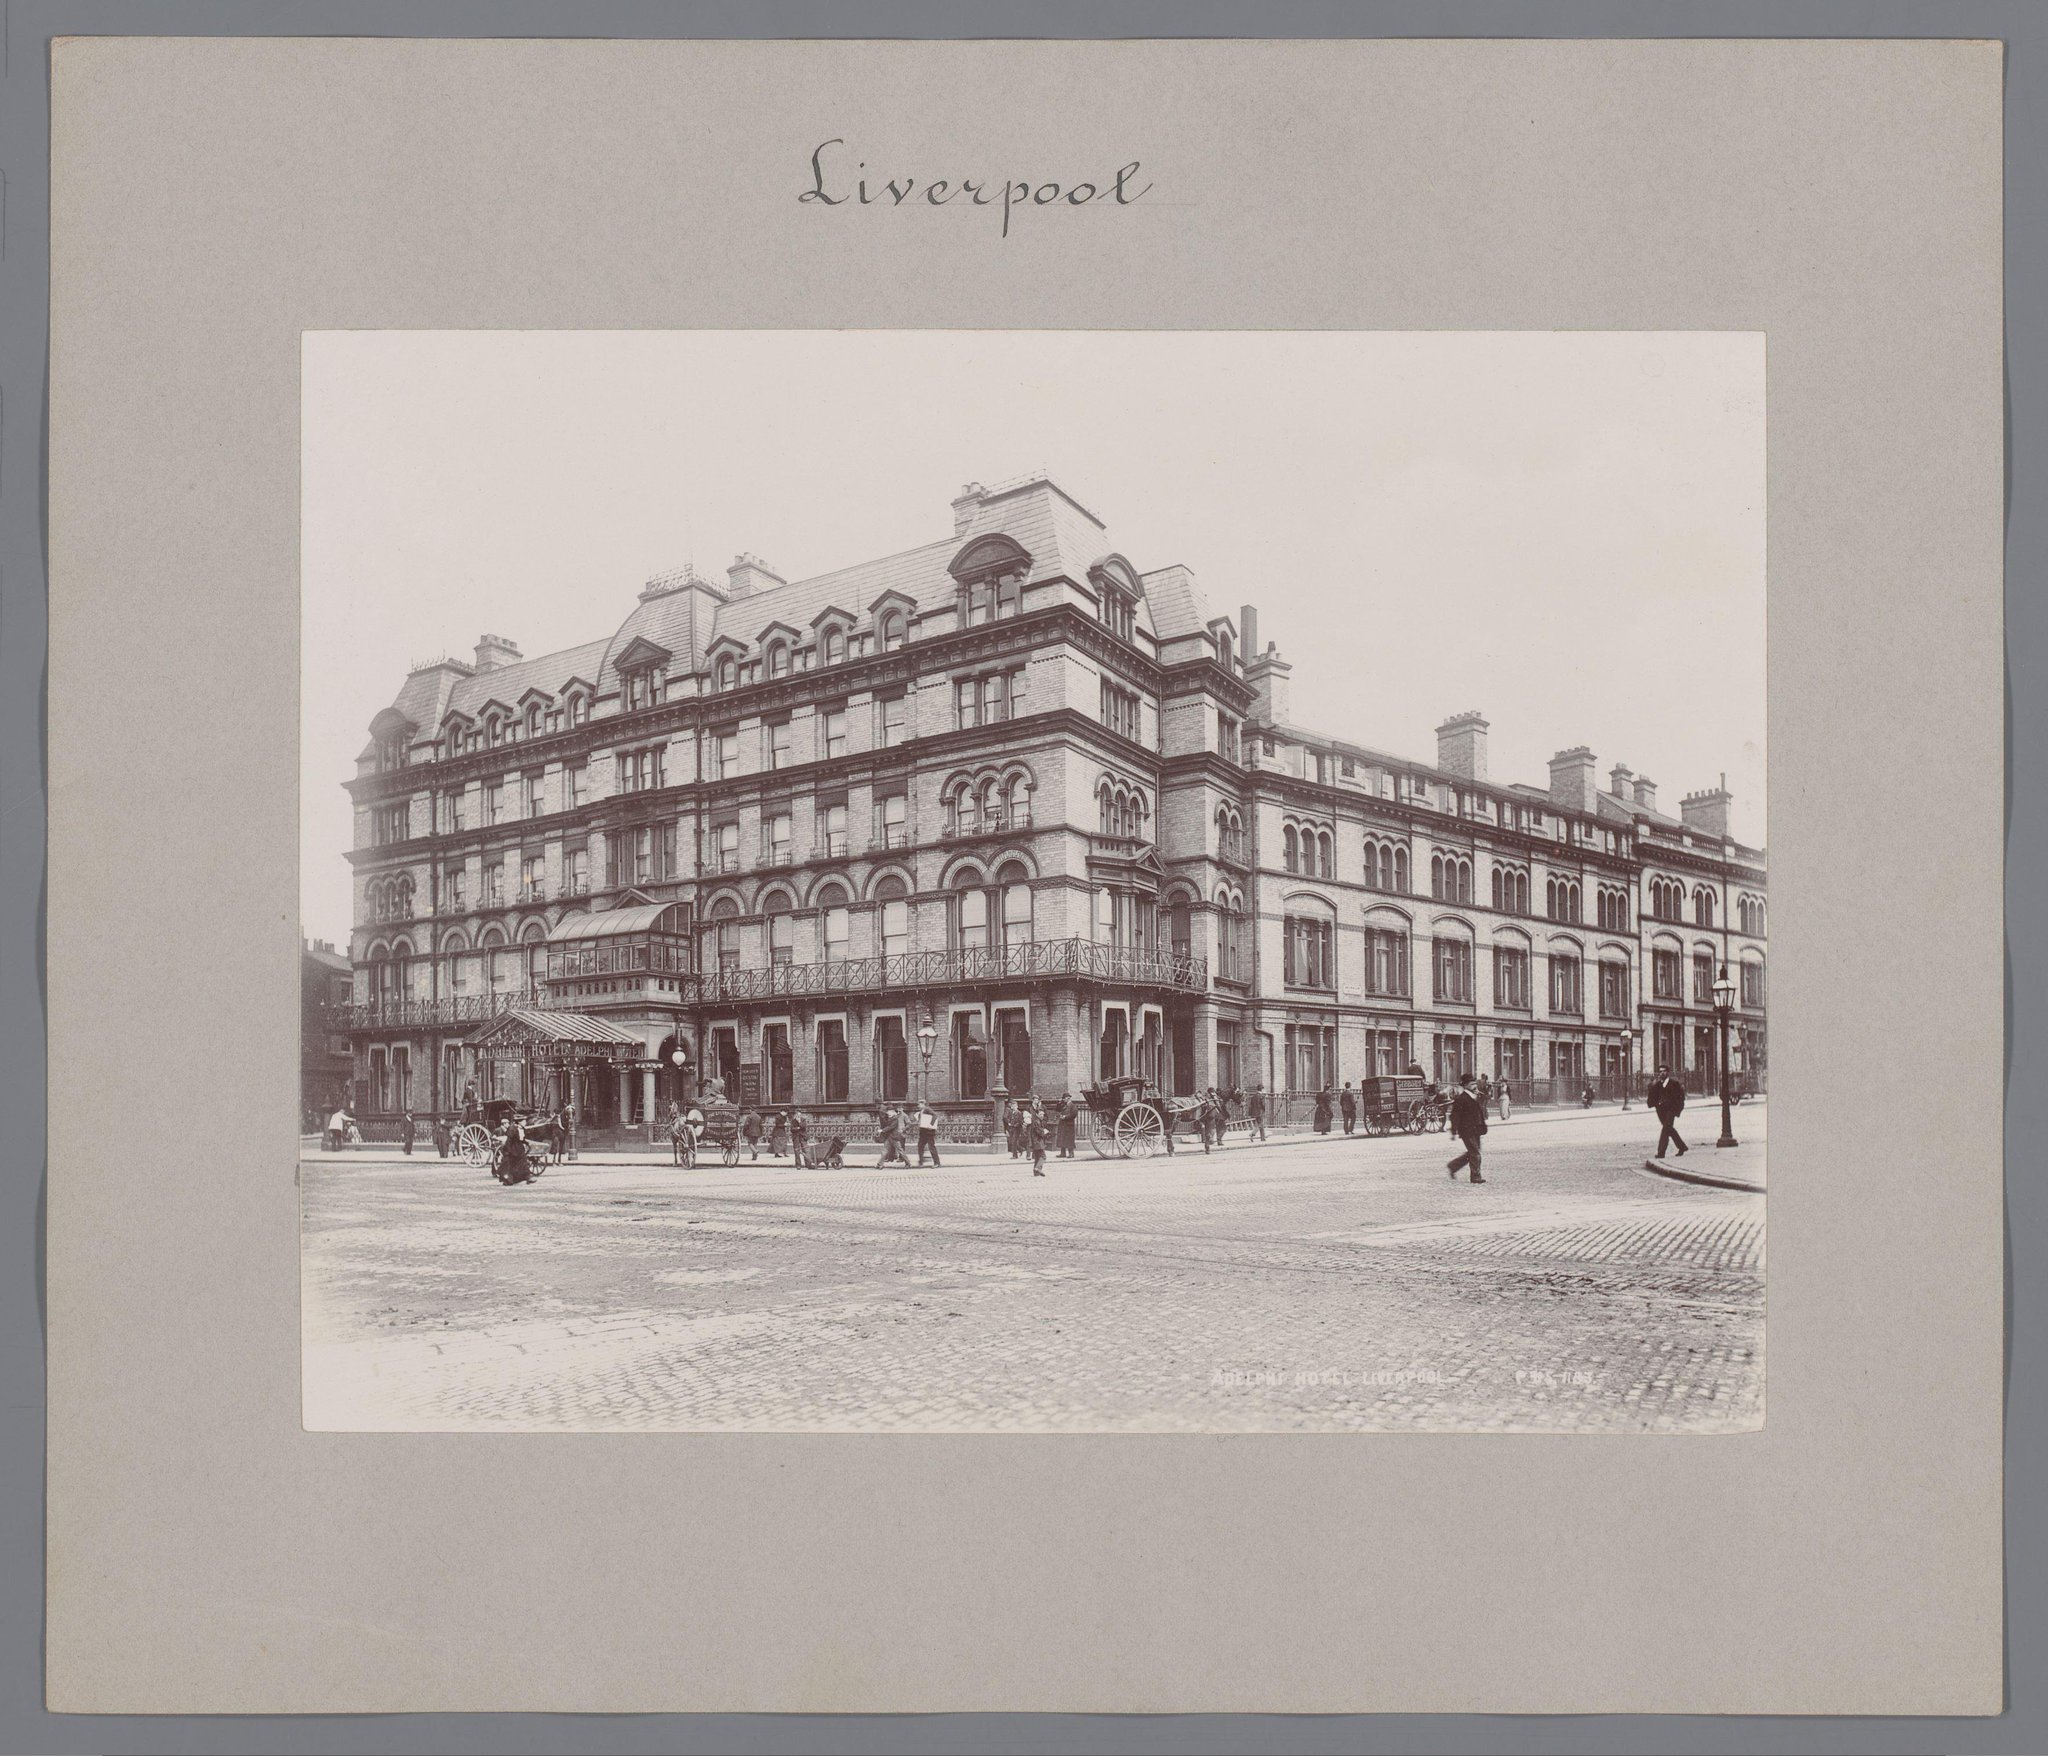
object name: album leaf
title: Adelphi Hotel, Liverpool, Engeland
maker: percy h. slater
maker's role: fotograaf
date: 1896-1900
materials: cardboard, paper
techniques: collodion silver print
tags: liverpool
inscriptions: inscription: ‘ADELPHI HOTEL LIVERPOOL P.H.S. 1183.’, inscription: ‘Liverpool’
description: Aanzicht op plein, met het hotel op de achtergrond.